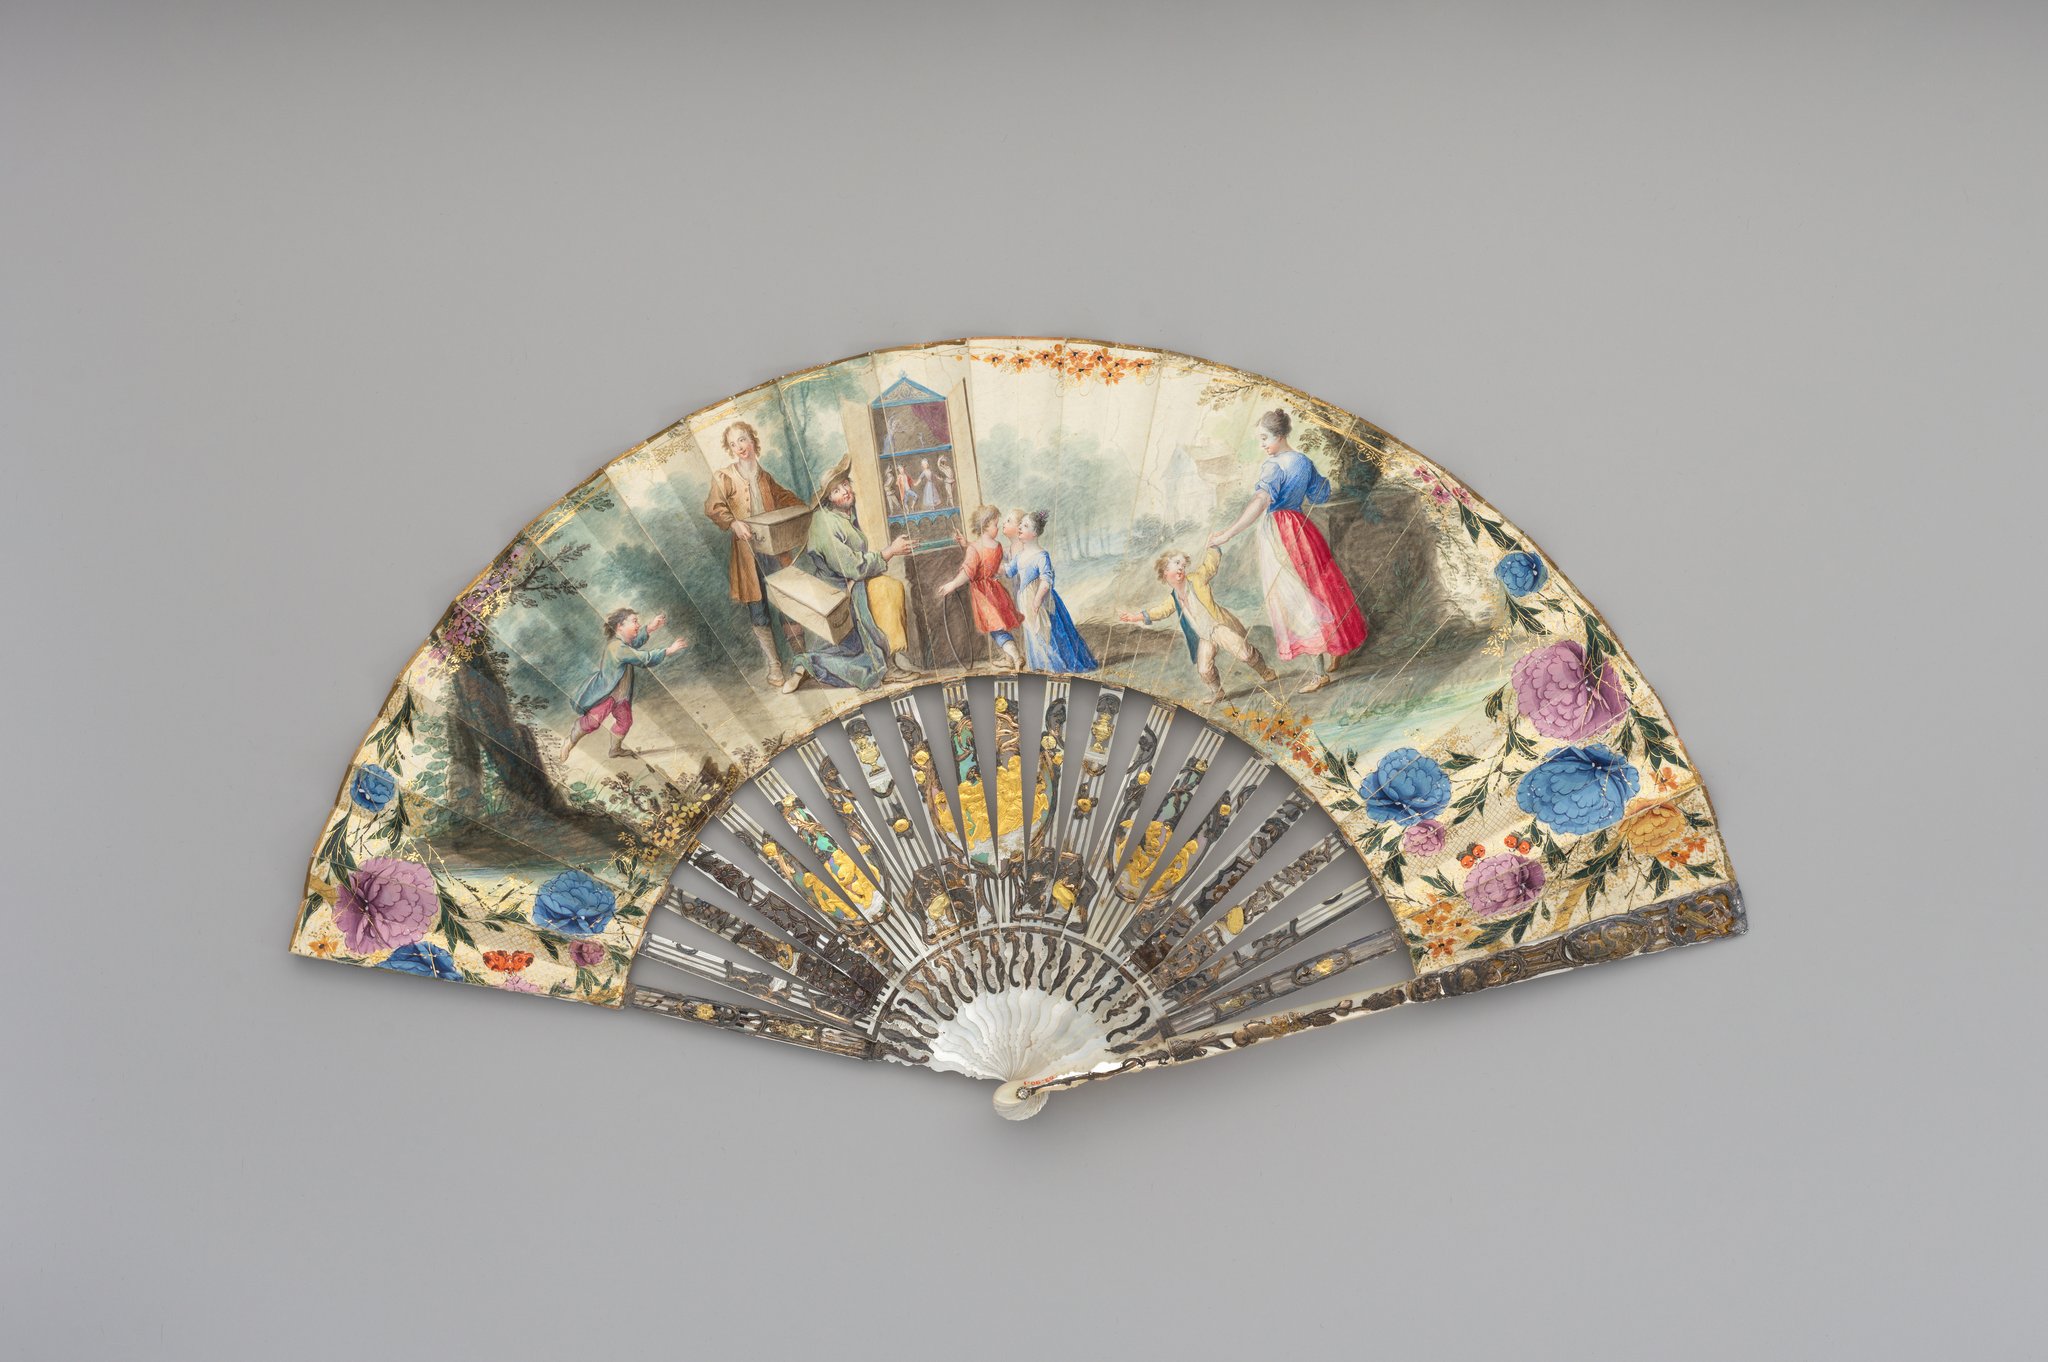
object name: fan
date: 1701-1800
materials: foil, glass, metal, mother of pearl, paper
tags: children,men,women,puppets